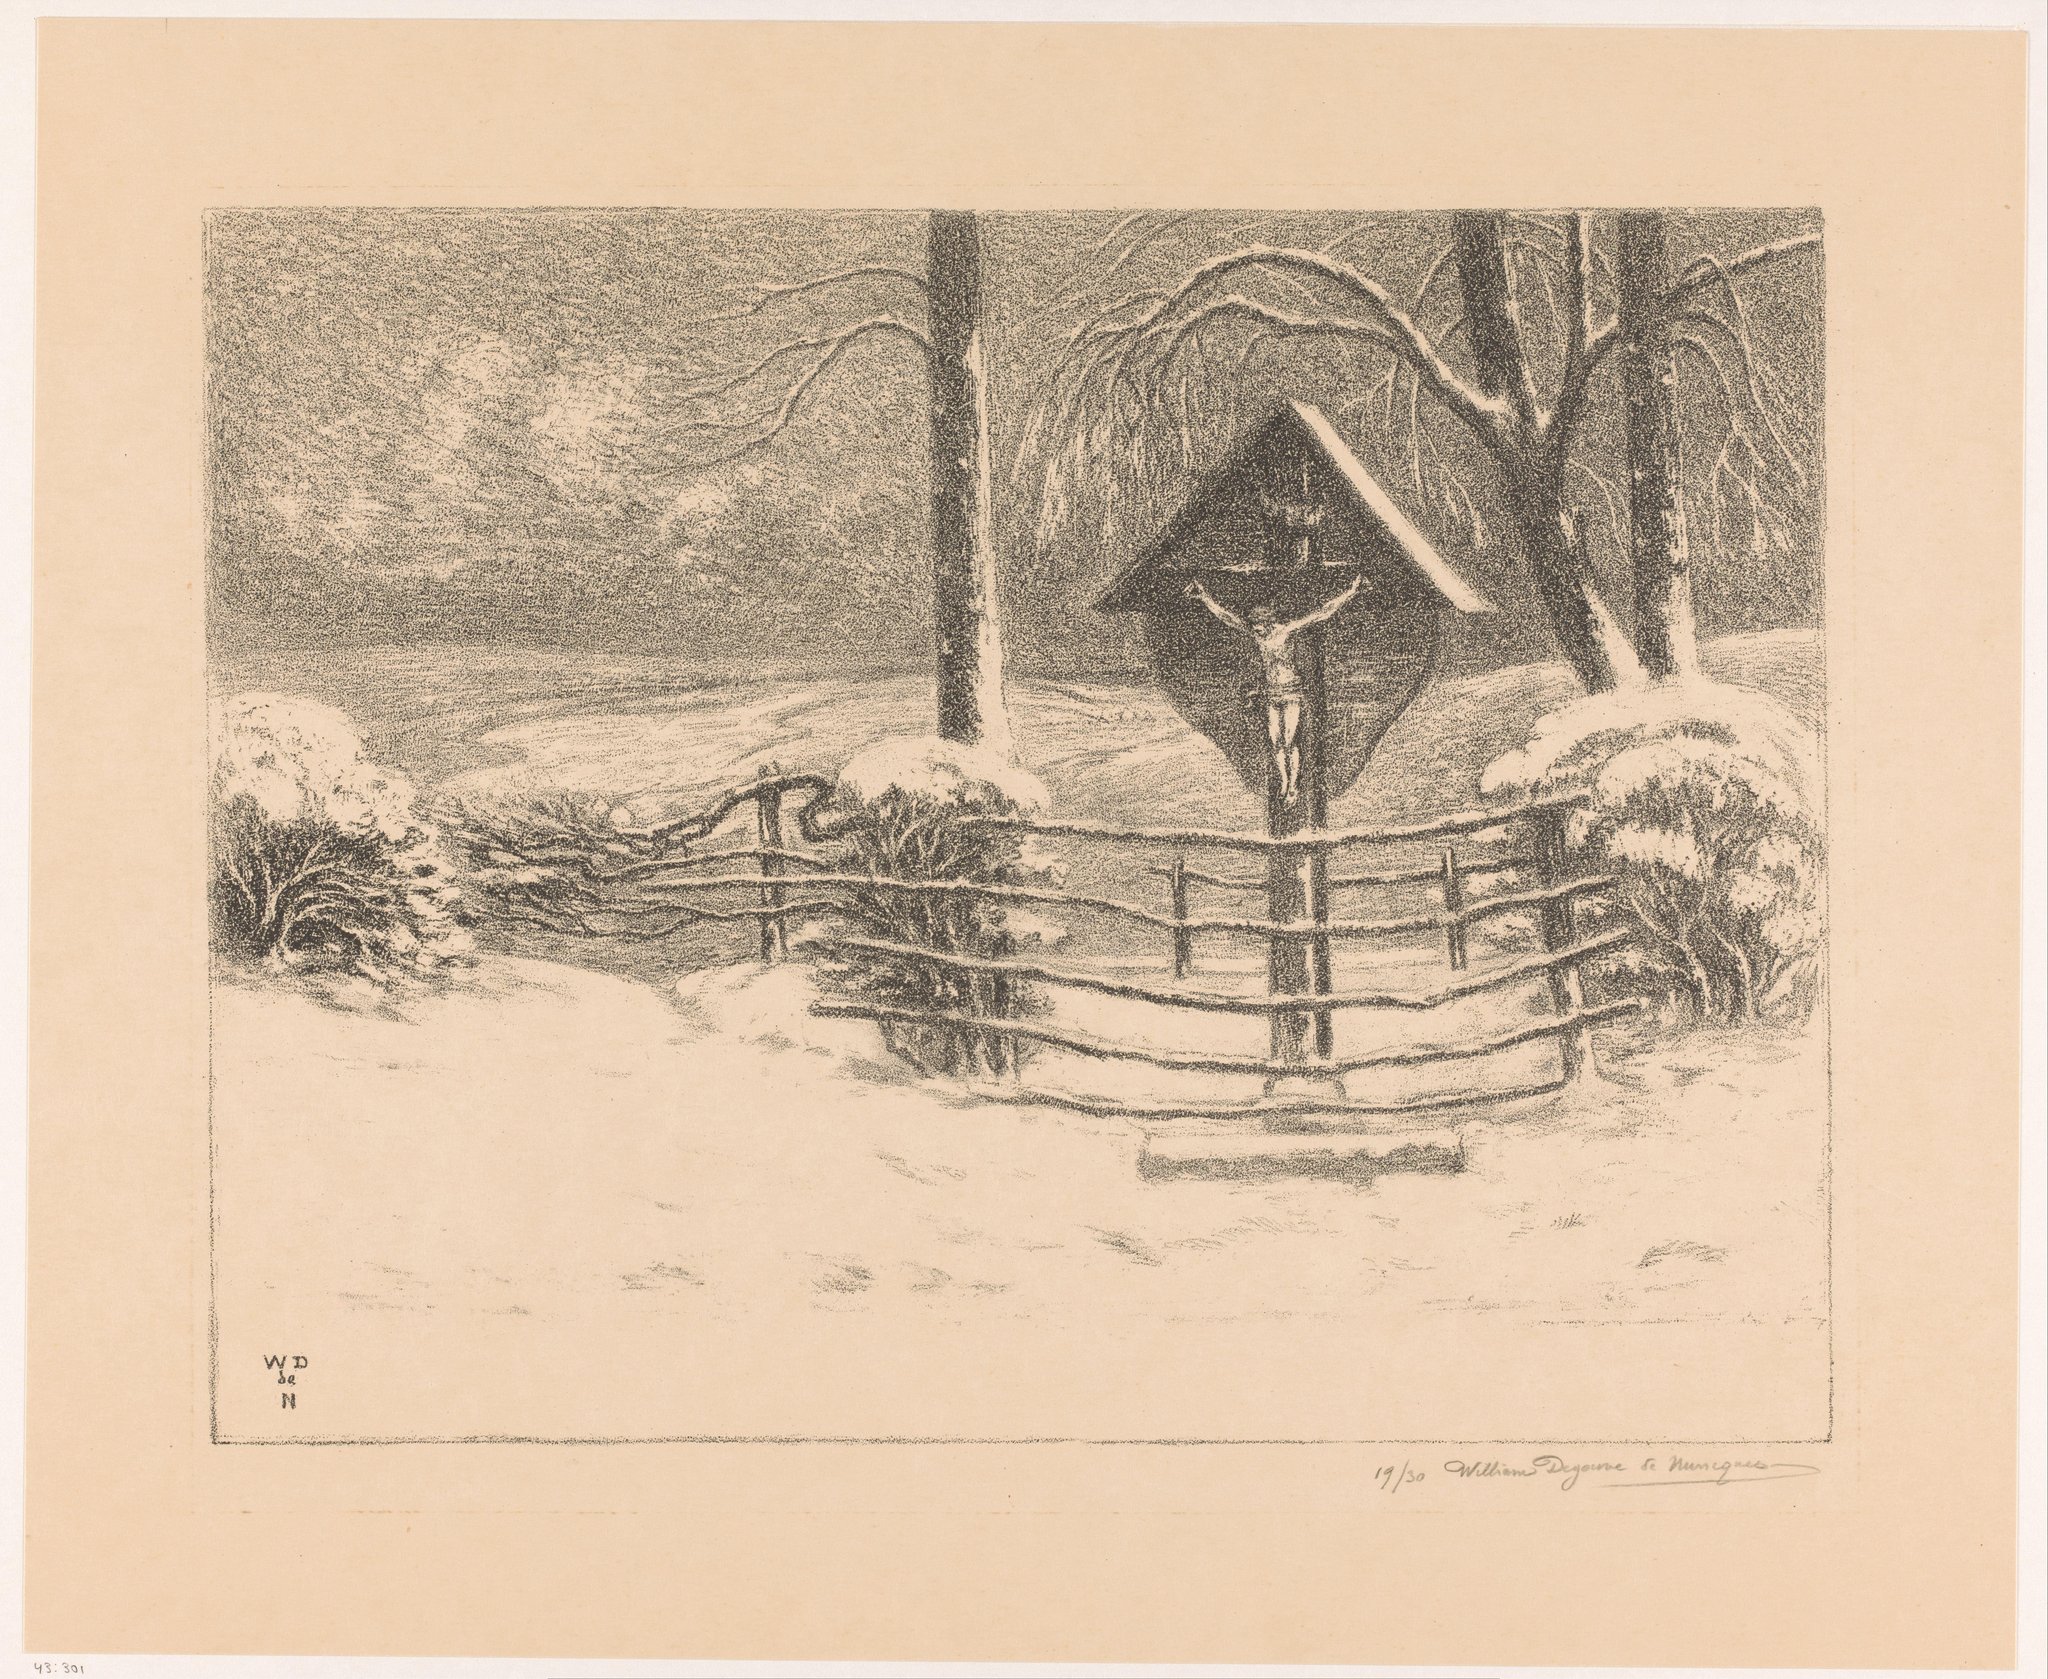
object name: print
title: Winterlandschap met crucifix in de Ardennen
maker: william degouve de nuncques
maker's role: draughtsman, print maker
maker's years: 1867-1935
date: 1877-1935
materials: paper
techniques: lithograph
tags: winter landscape; landscape symbolizing winter (the four seasons of the year), crucifix ~ personal devotion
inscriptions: collector's mark: Lugt 2228, collector's mark: Lugt 2760